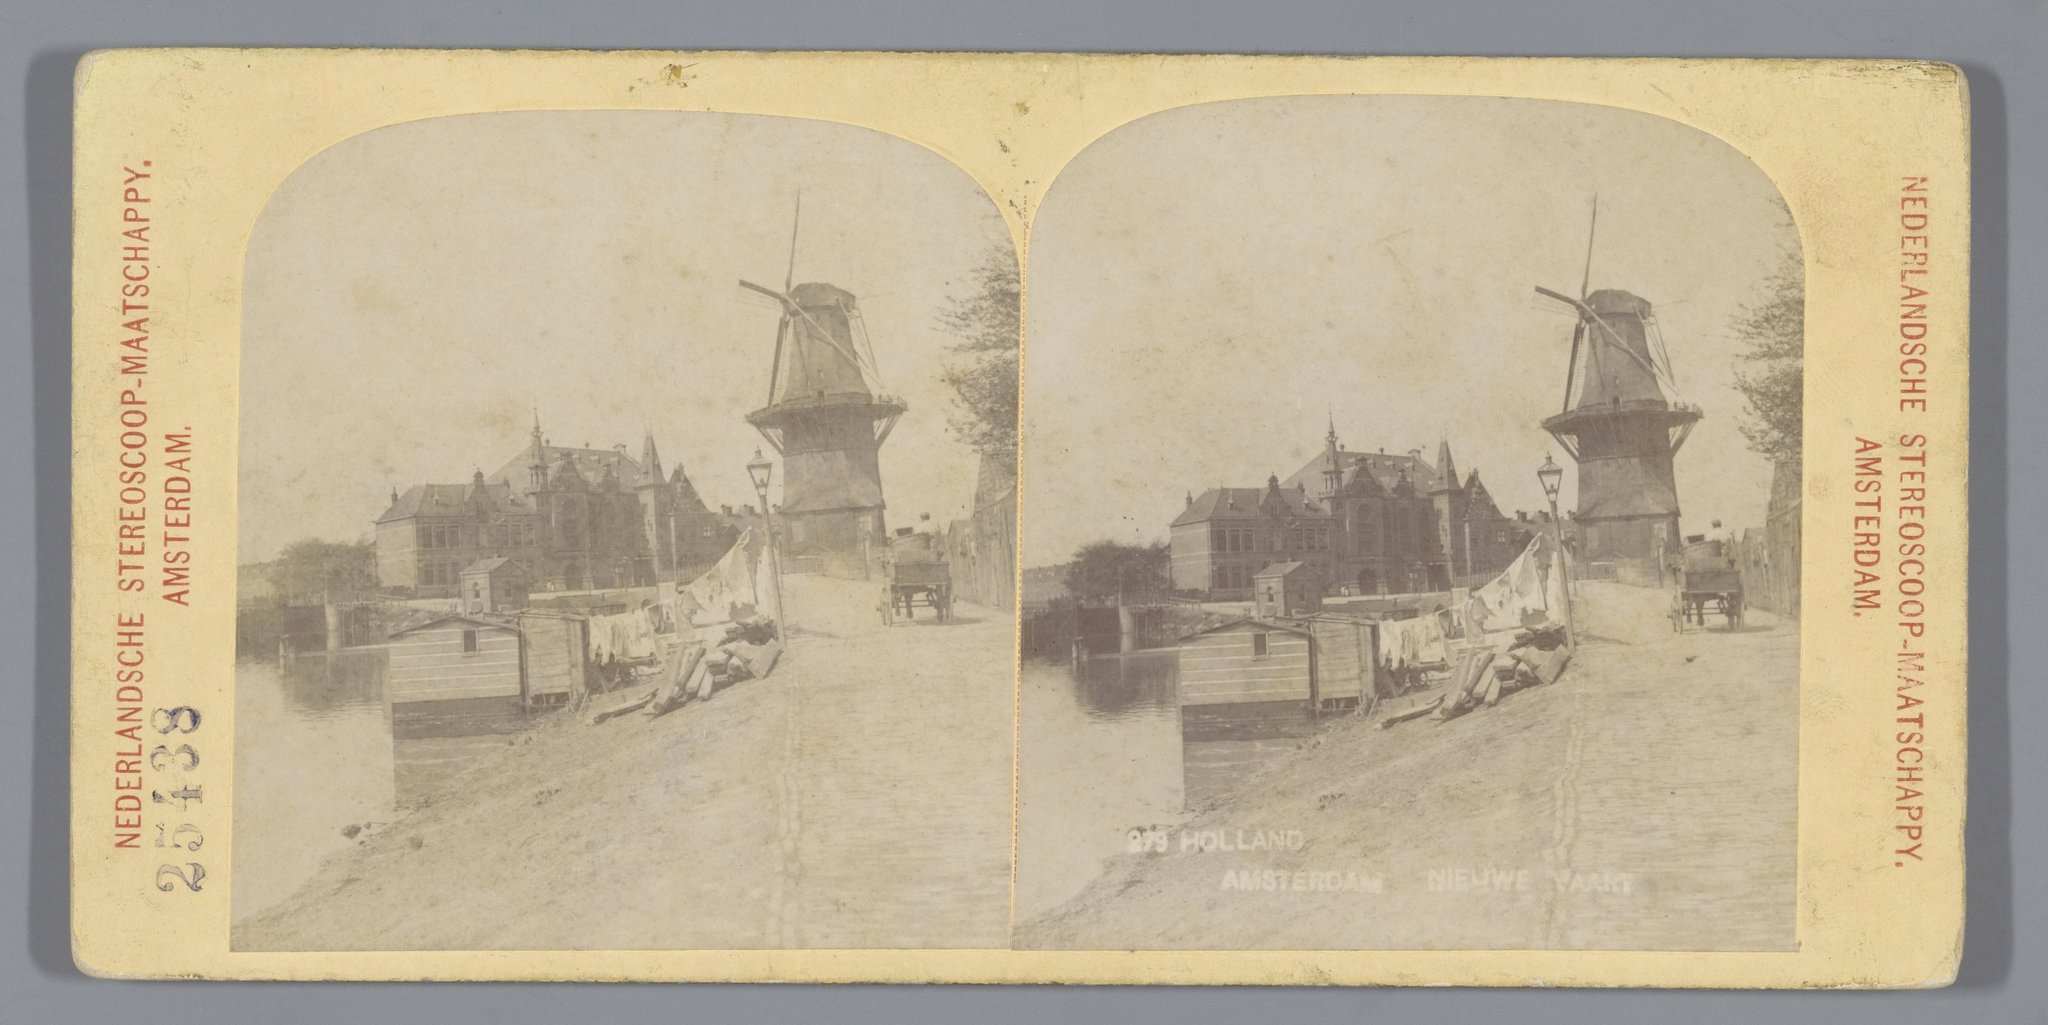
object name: stereograph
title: Molen de Gooyer aan de Nieuwe Vaart, Amsterdam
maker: j.g. beers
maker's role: fotograaf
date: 1857-1863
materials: cardboard, paper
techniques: albumen print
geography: amsterdam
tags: canals, waters (in city), windmill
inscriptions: number: ‘25438’, number: ‘279’